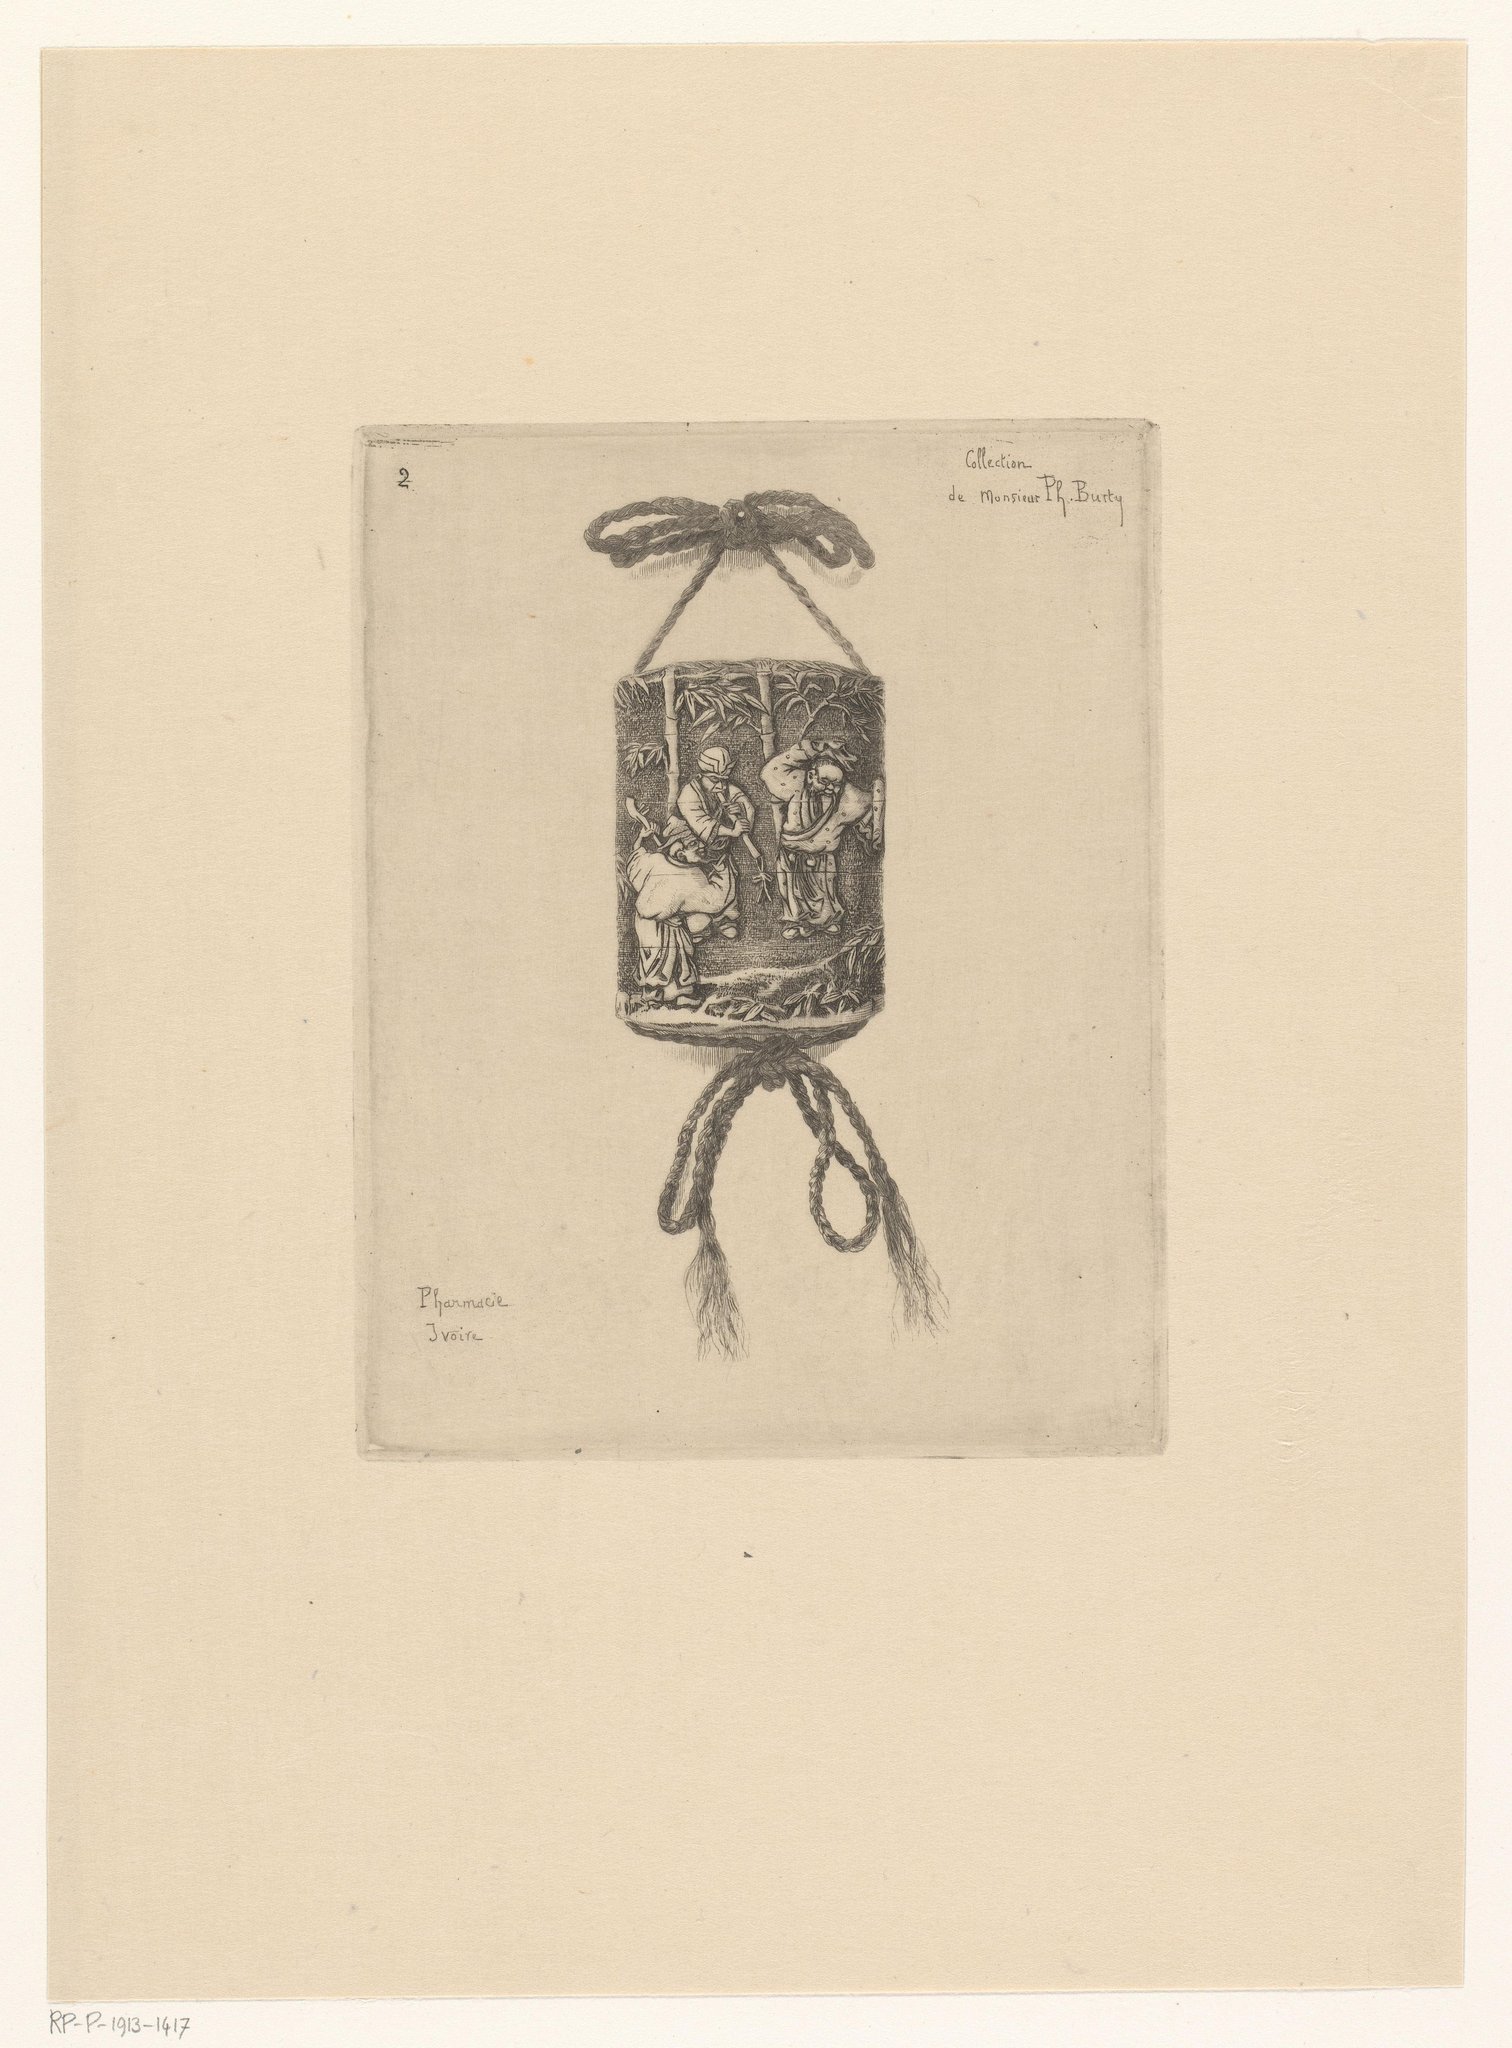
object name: print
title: Japonisme. Dix Eaux-Fortes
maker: félix hilaire buhot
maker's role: draughtsman, print maker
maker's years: 1847-1898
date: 1883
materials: paper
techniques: aquatint, etching, intaglio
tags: musician, piece of sculpture, reproduction of a piece of sculpture, japanese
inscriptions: collector's mark: Lugt 2233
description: Prent uit een serie bestaande uit acht platen plus titelprent en ex libris, naar Japanse objecten uit de collectie van Philippe Burty, uitgegeven in Parijs door Edmond Sagot in (april) 1883. In dat jaar vond er een belangrijke tentoonstelling plaats evenals andere Japan-georiënteerde activiteiten. Op 10 april 1883 opende de eerste retrospectieve tentoonstelling van Japanse kunst in de Westerse wereld in de Gallery Georges Petit op de Rue de Sèze te Parijs. Volgens een brief van Buhot aan Octave Uzanne, gedateerd 4 april 1883, had Buhot in 1875 reeds negen van de tien platen vervaardigd. Bourcard & Goodfriend vermelden dat er van de serie vijftig waren gedrukt op Japans papier, honderd op Nederlands papier en enkelen op geel met goud bewerkt papier.